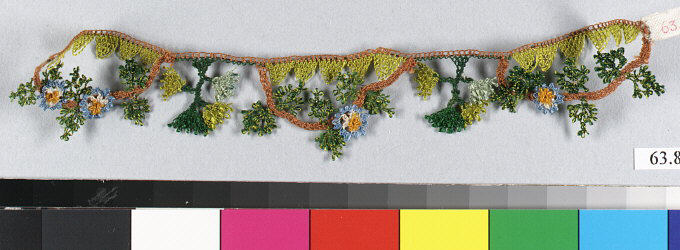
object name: piece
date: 1801-1900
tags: flowers